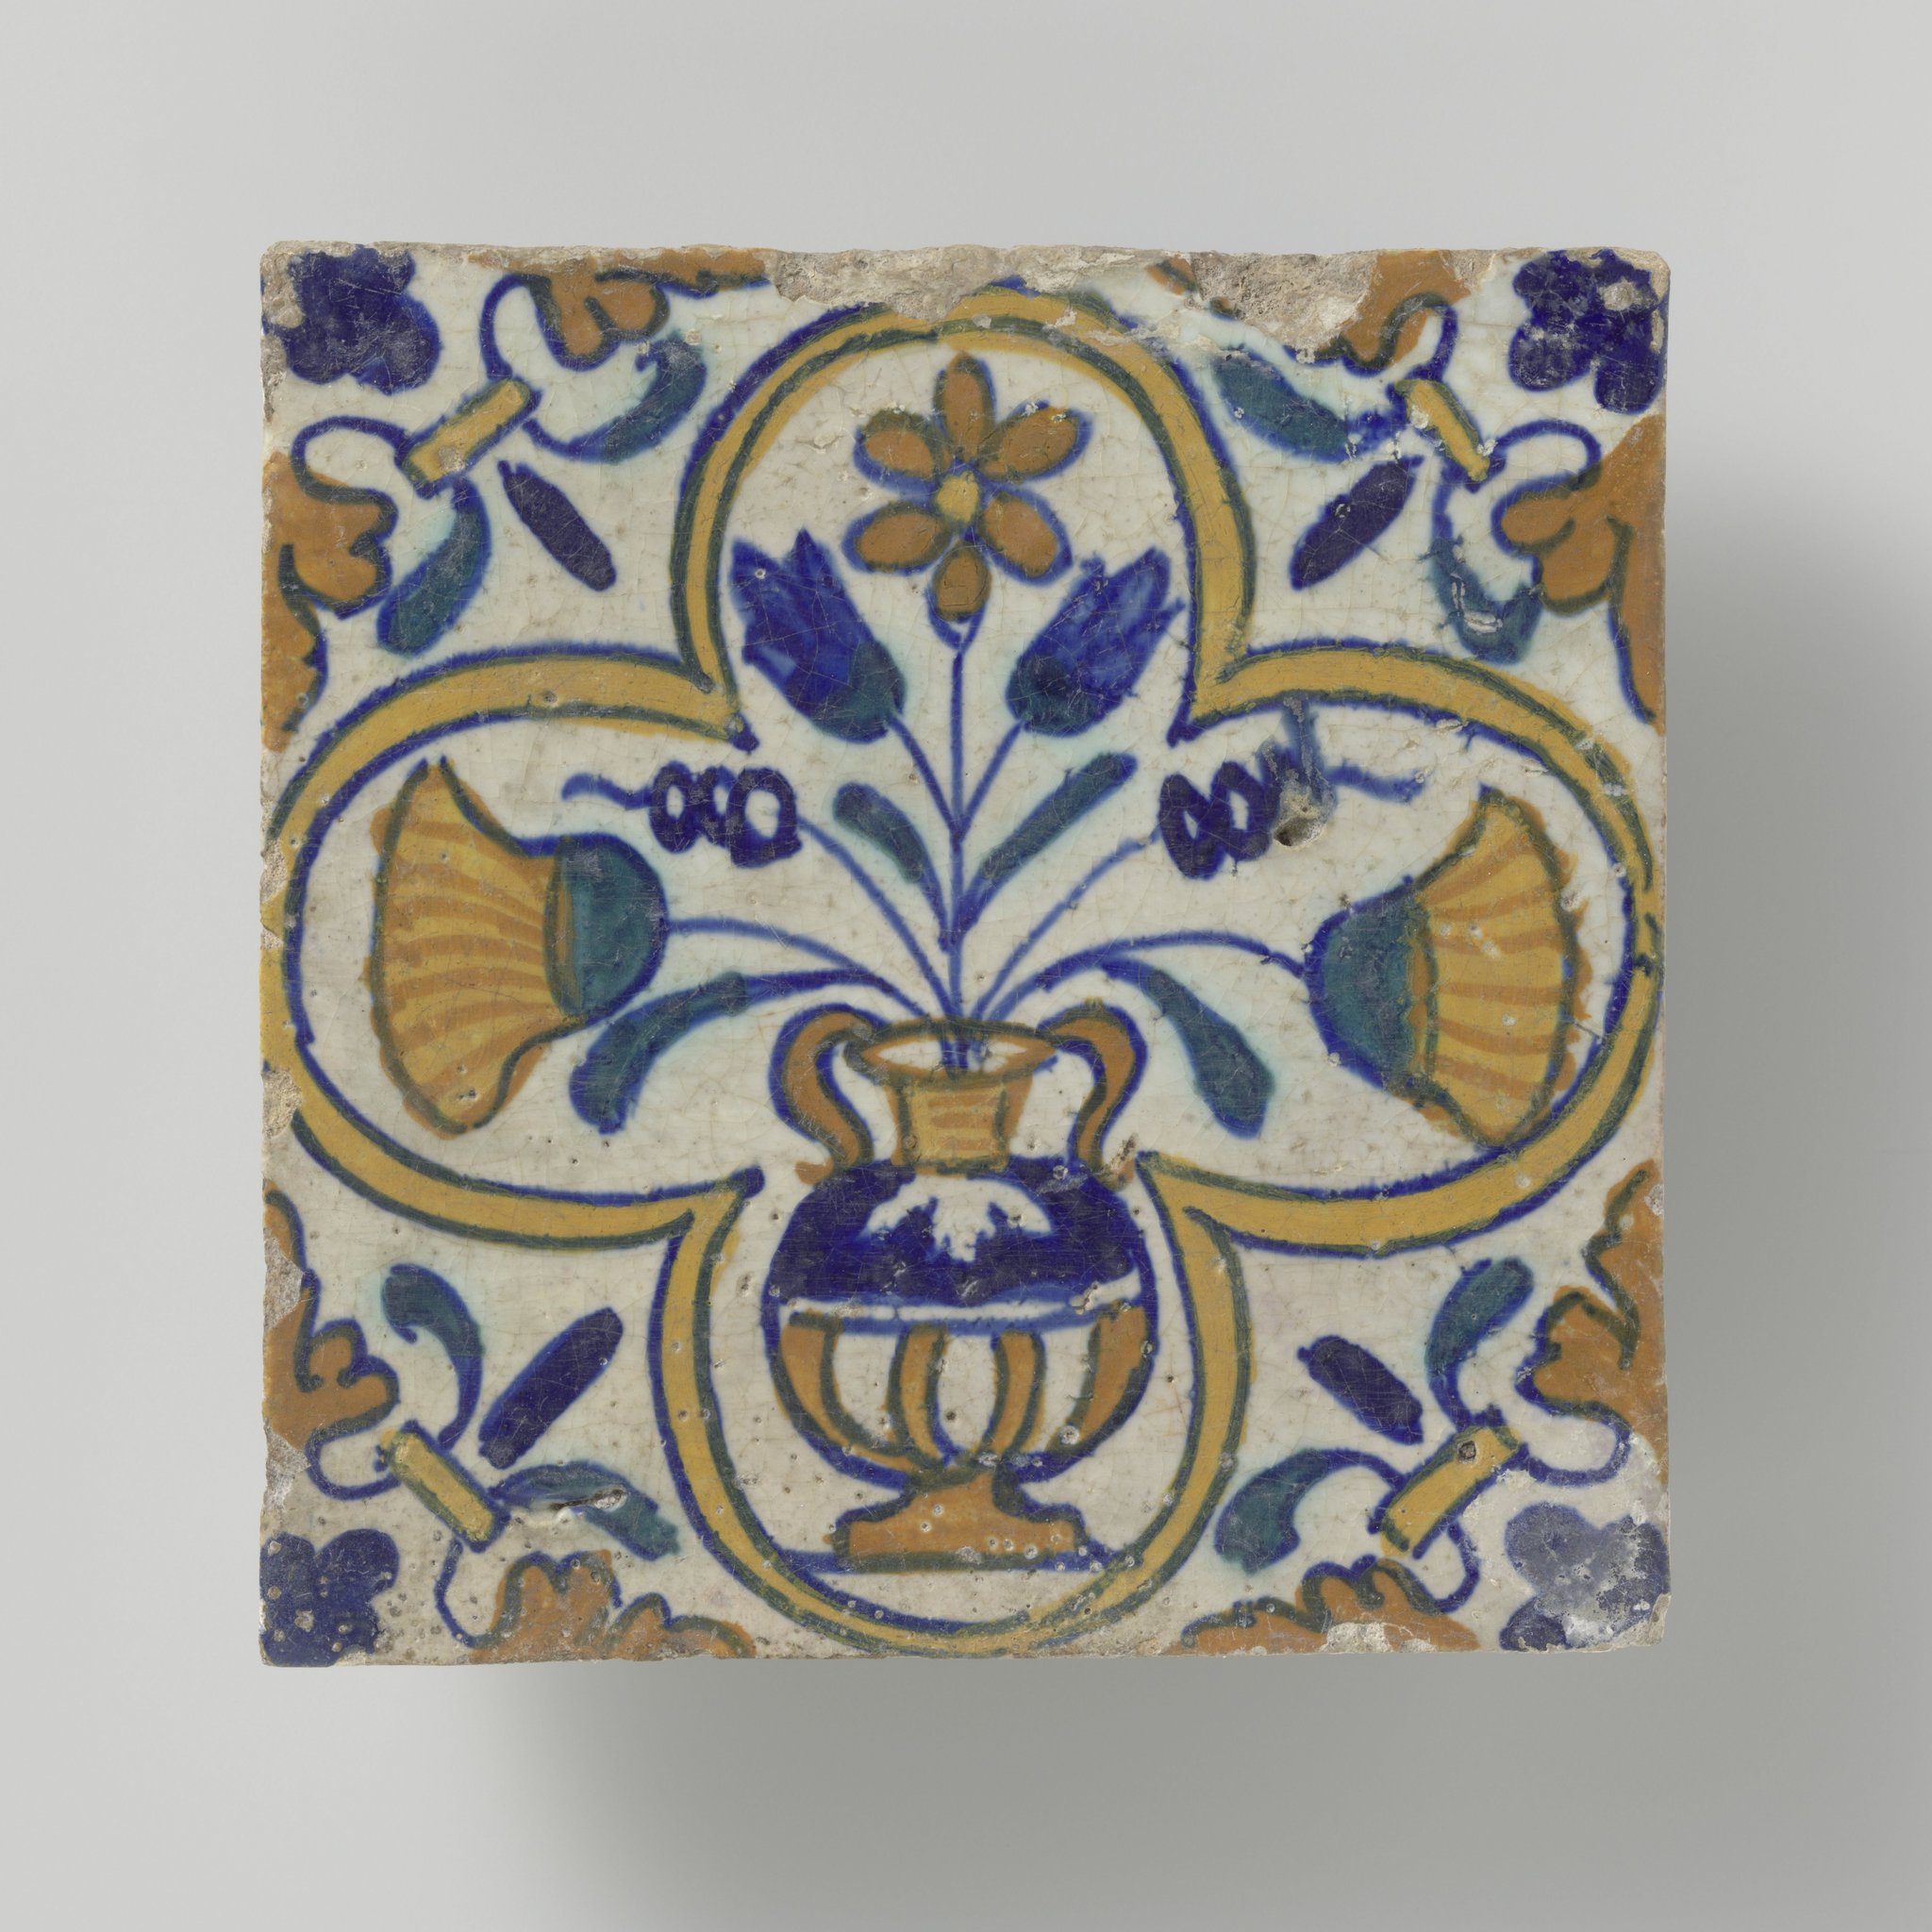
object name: pompadourtegel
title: Pompadourtegel met bloempot in vierpas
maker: Anonymous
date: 1610-1630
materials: earthenware, glaze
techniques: maiolica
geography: netherlands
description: Pompadourtegel met een veelkleurige (blauw, oranje, groen en geel) bloempot binnen een vierpas omlijsting. In de hoeken, een lelie.